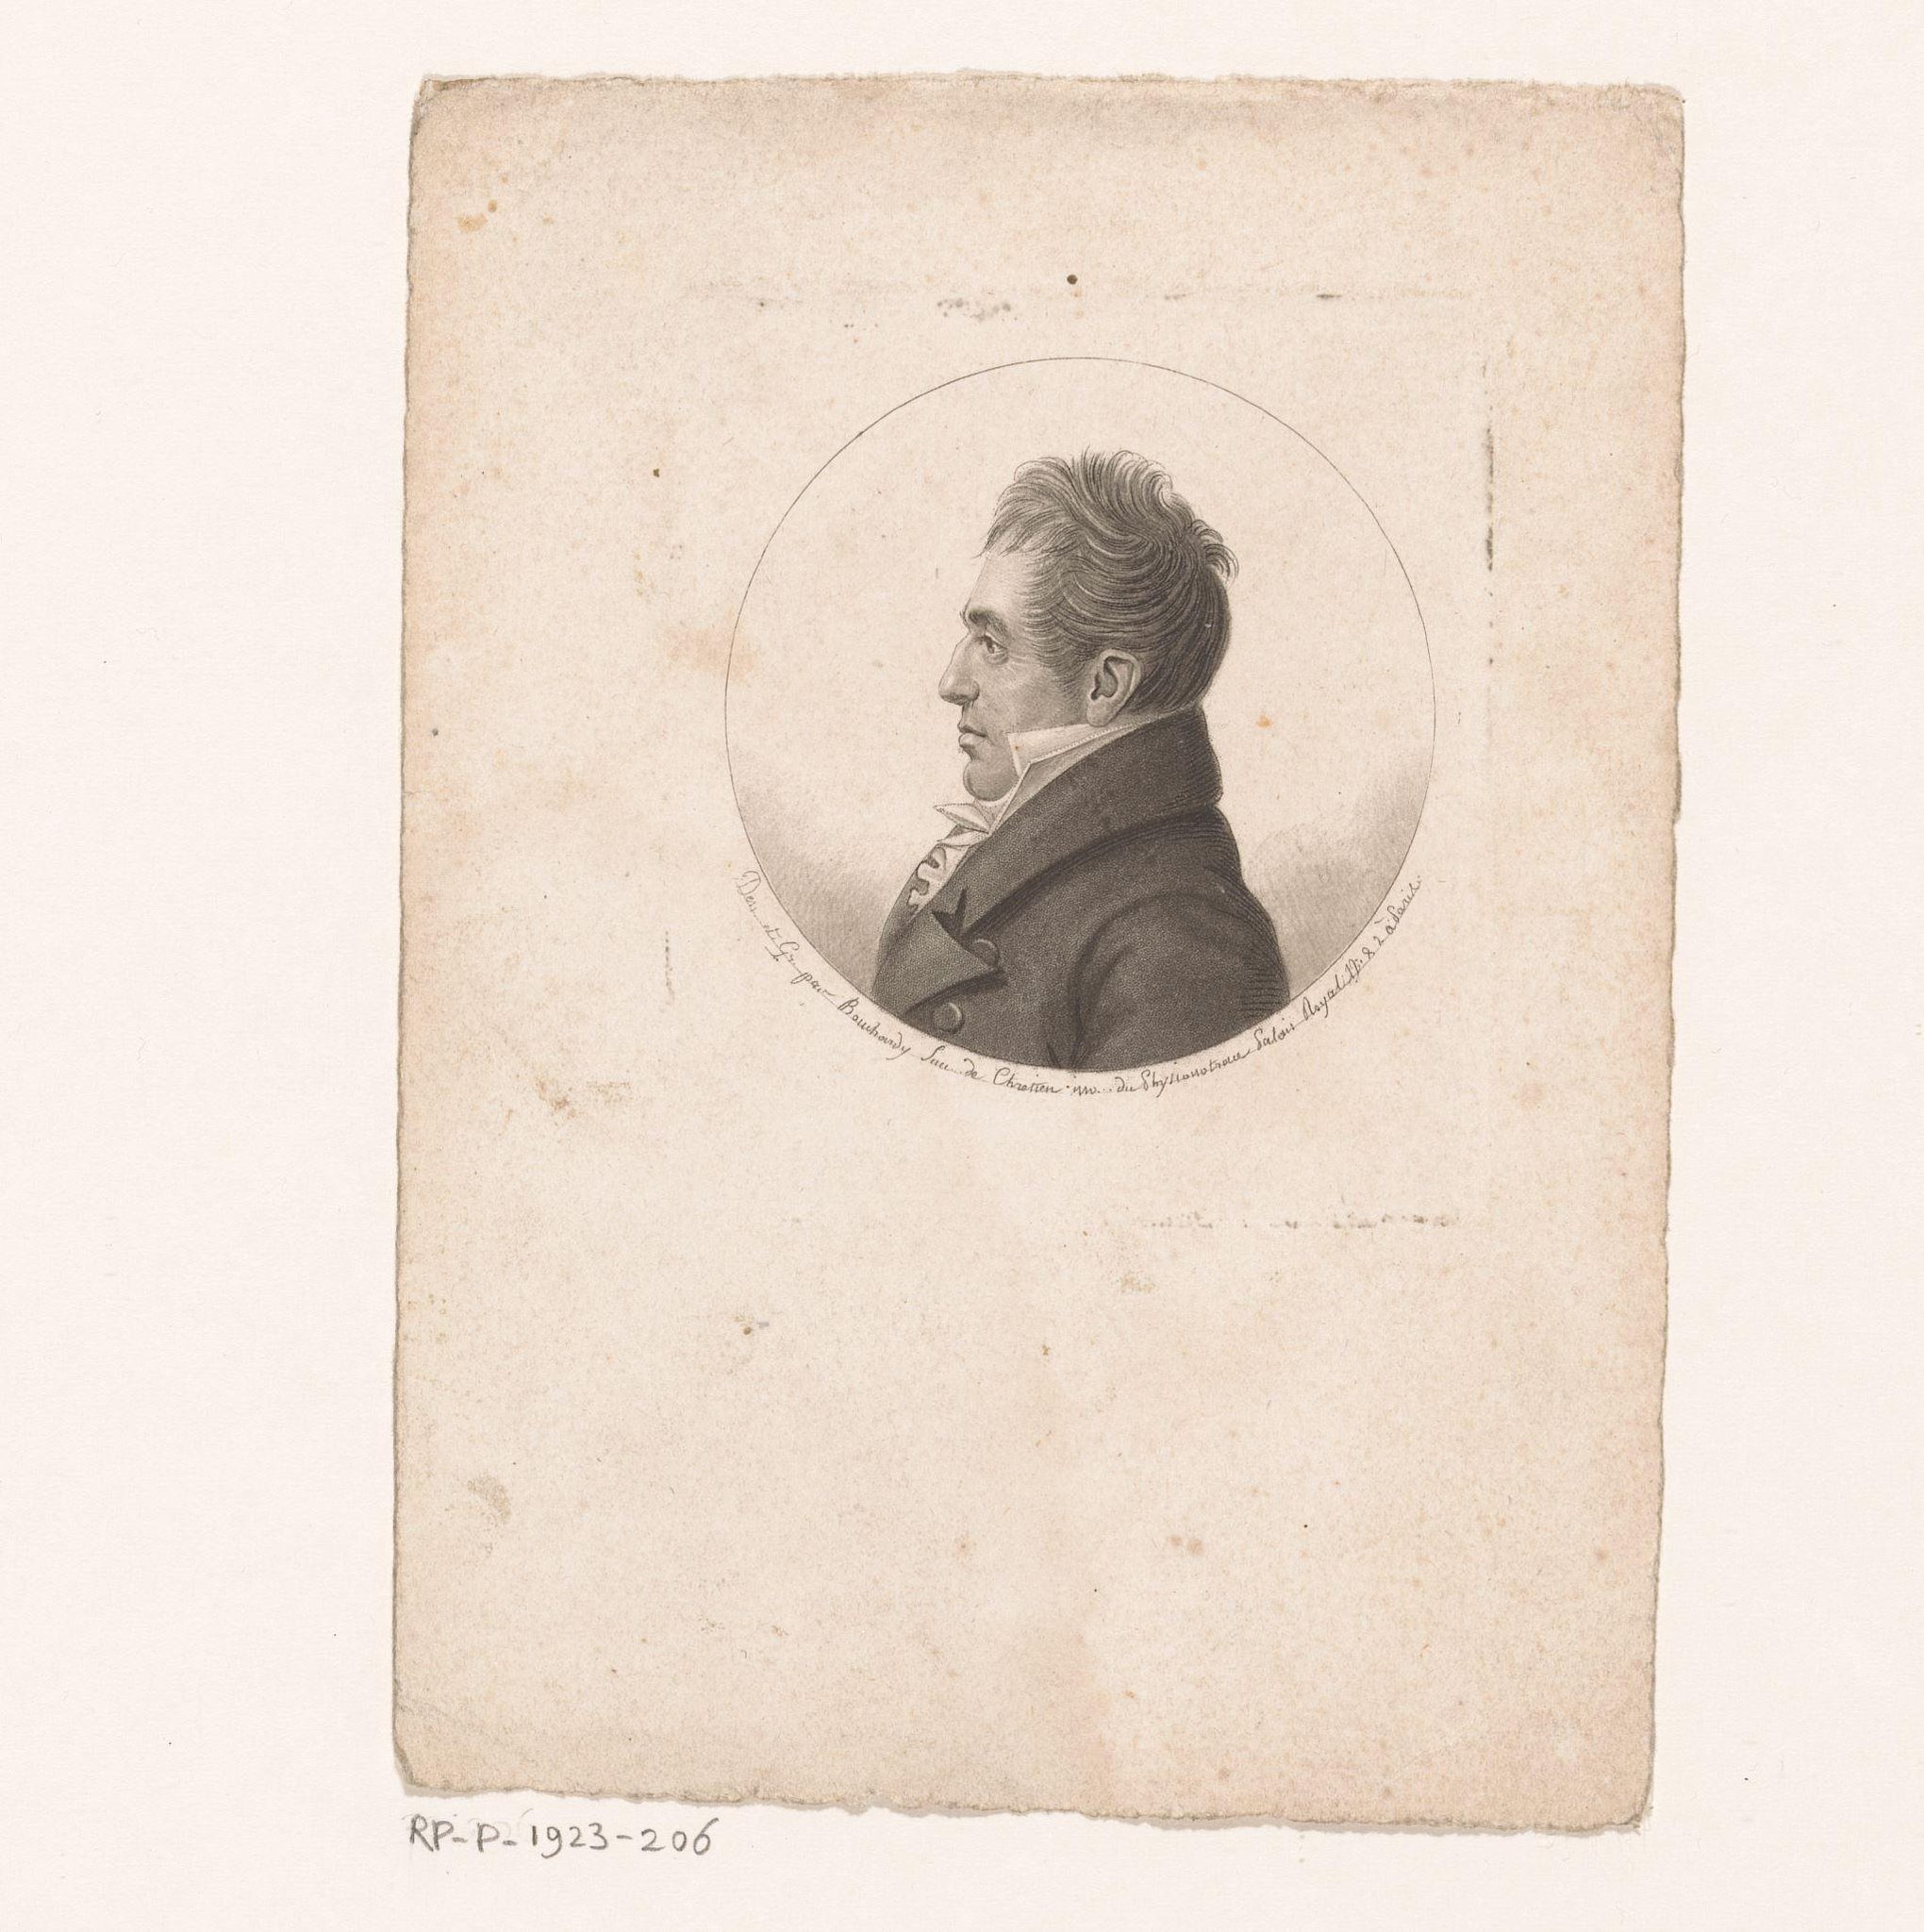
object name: print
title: Portret van een onbekende man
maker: etienne bouchardy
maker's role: print maker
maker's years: 1797-1849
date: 1807-1849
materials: paper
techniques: aquatint, etching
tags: historical persons (portraits and scenes from the life)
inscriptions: collector's mark: Lugt 2233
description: Dit portret werd volgens het opschrift vervaardigd met behulp van een physionotrace, waarmee de contouren van een gezicht op een stuk papier konden worden overgebracht.